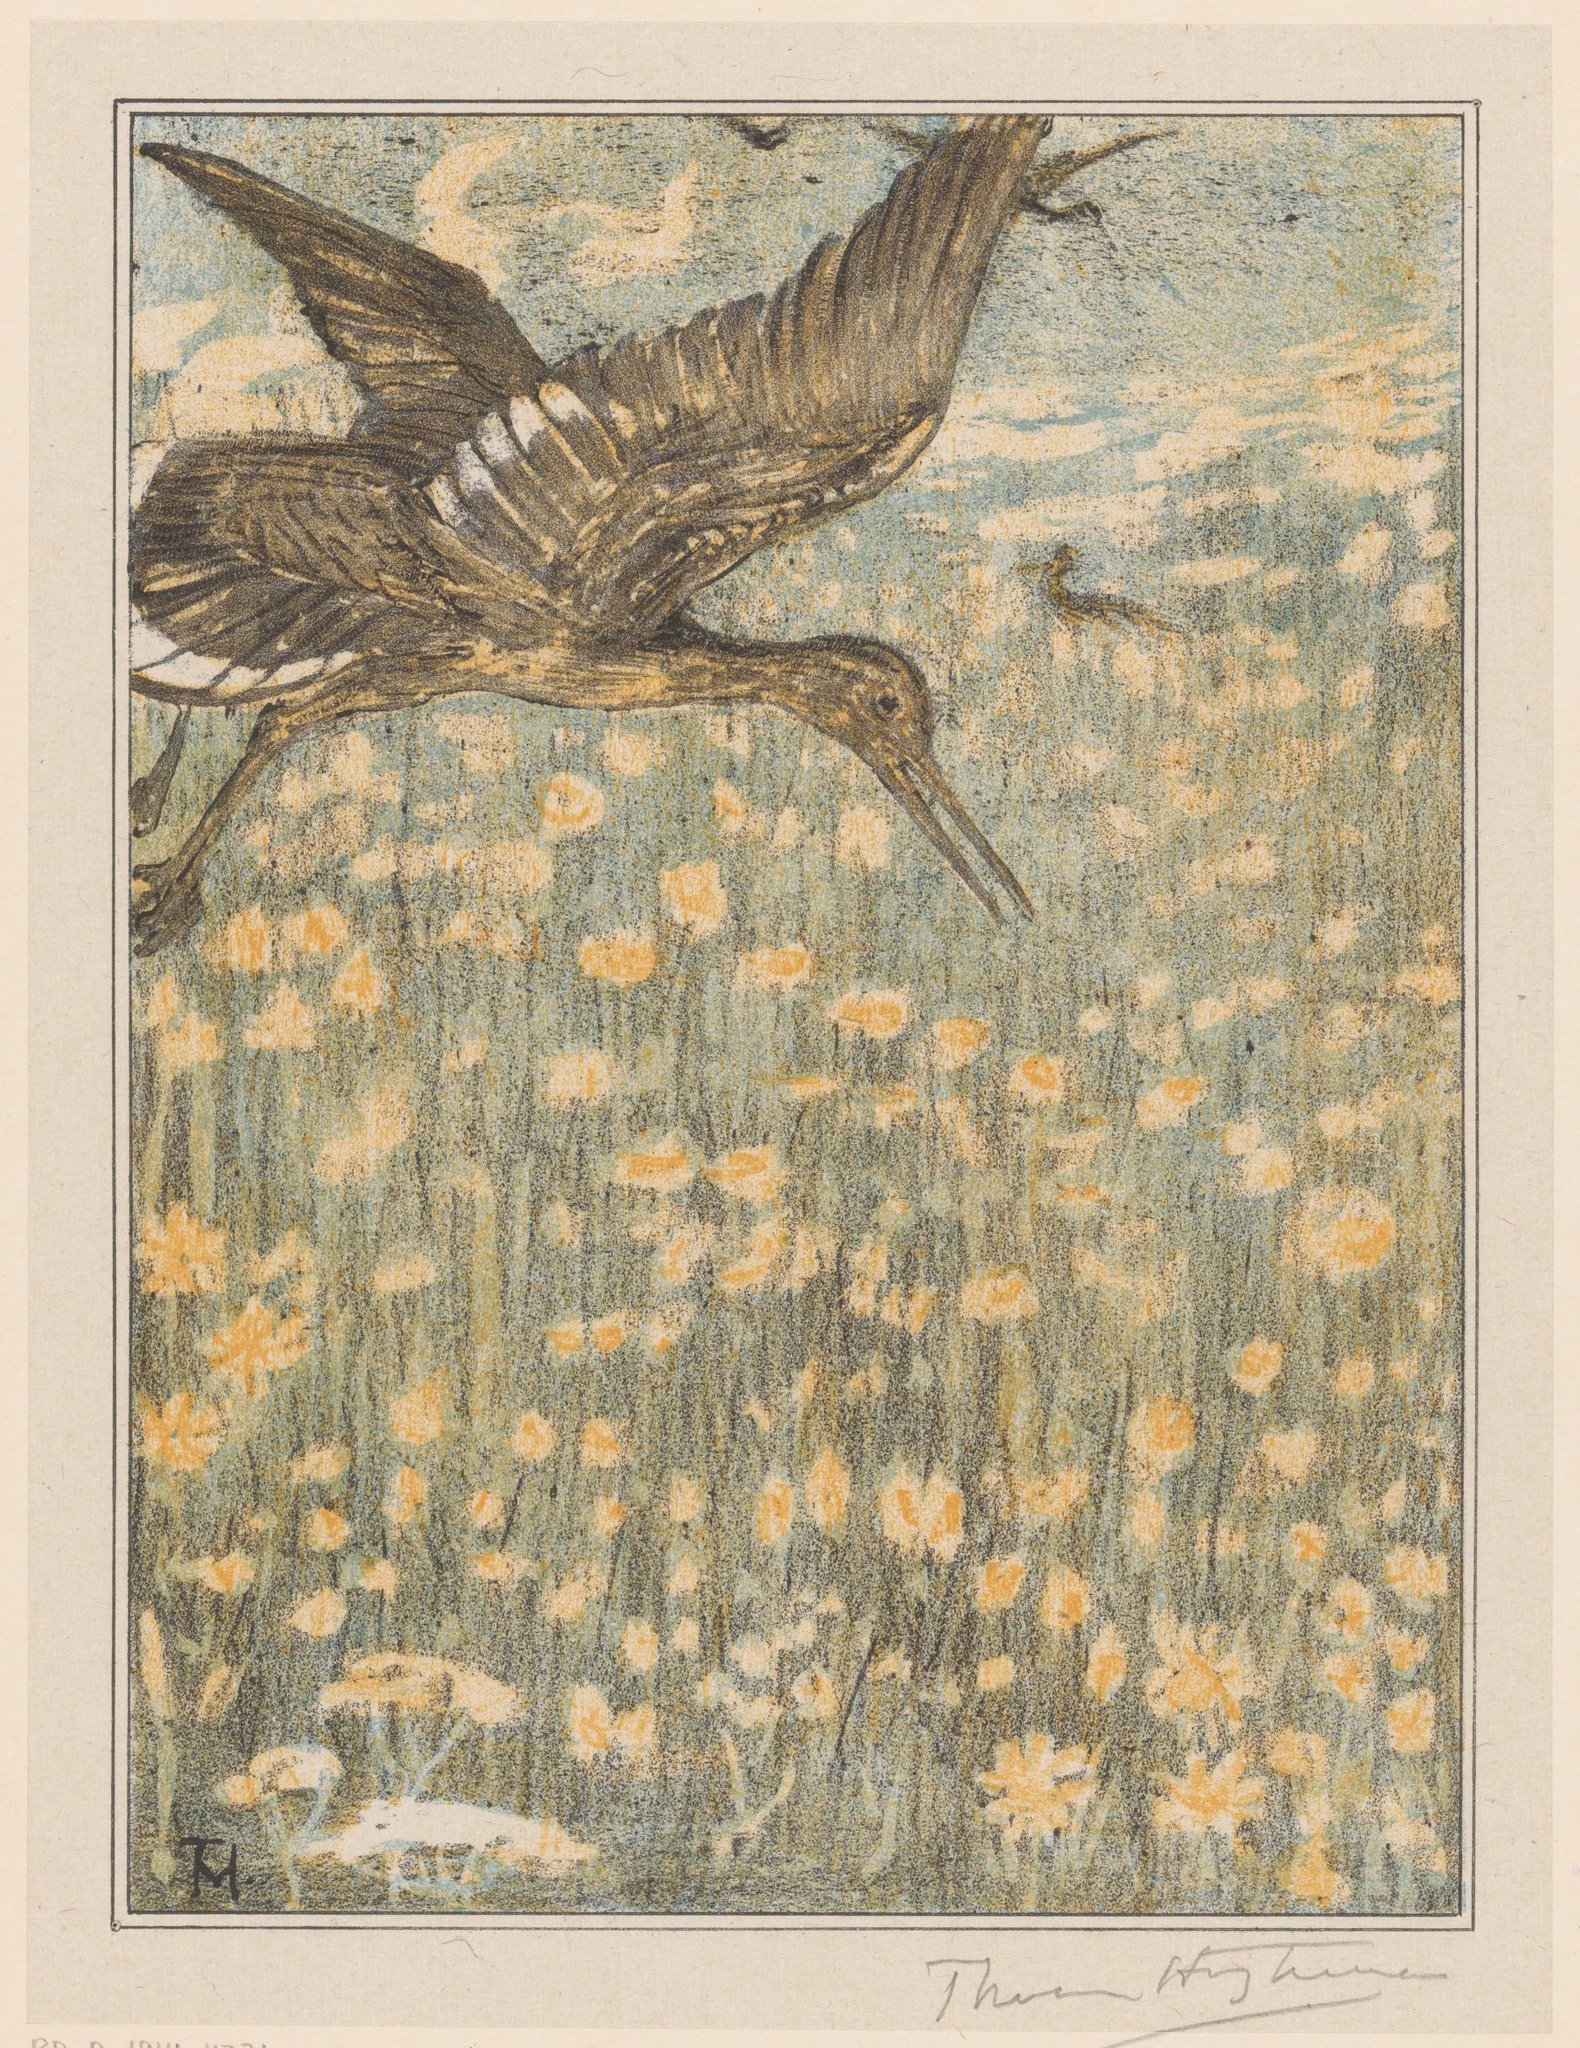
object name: print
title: Tureluur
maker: theo van hoytema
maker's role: draughtsman, painter, print maker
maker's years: 1863-1917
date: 1878-1907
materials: paper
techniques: lithograph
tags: flowers, shore-birds and wading-birds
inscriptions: collector's mark: Lugt 2233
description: Prent is een proefdruk voor kalenderblad juli 1907.